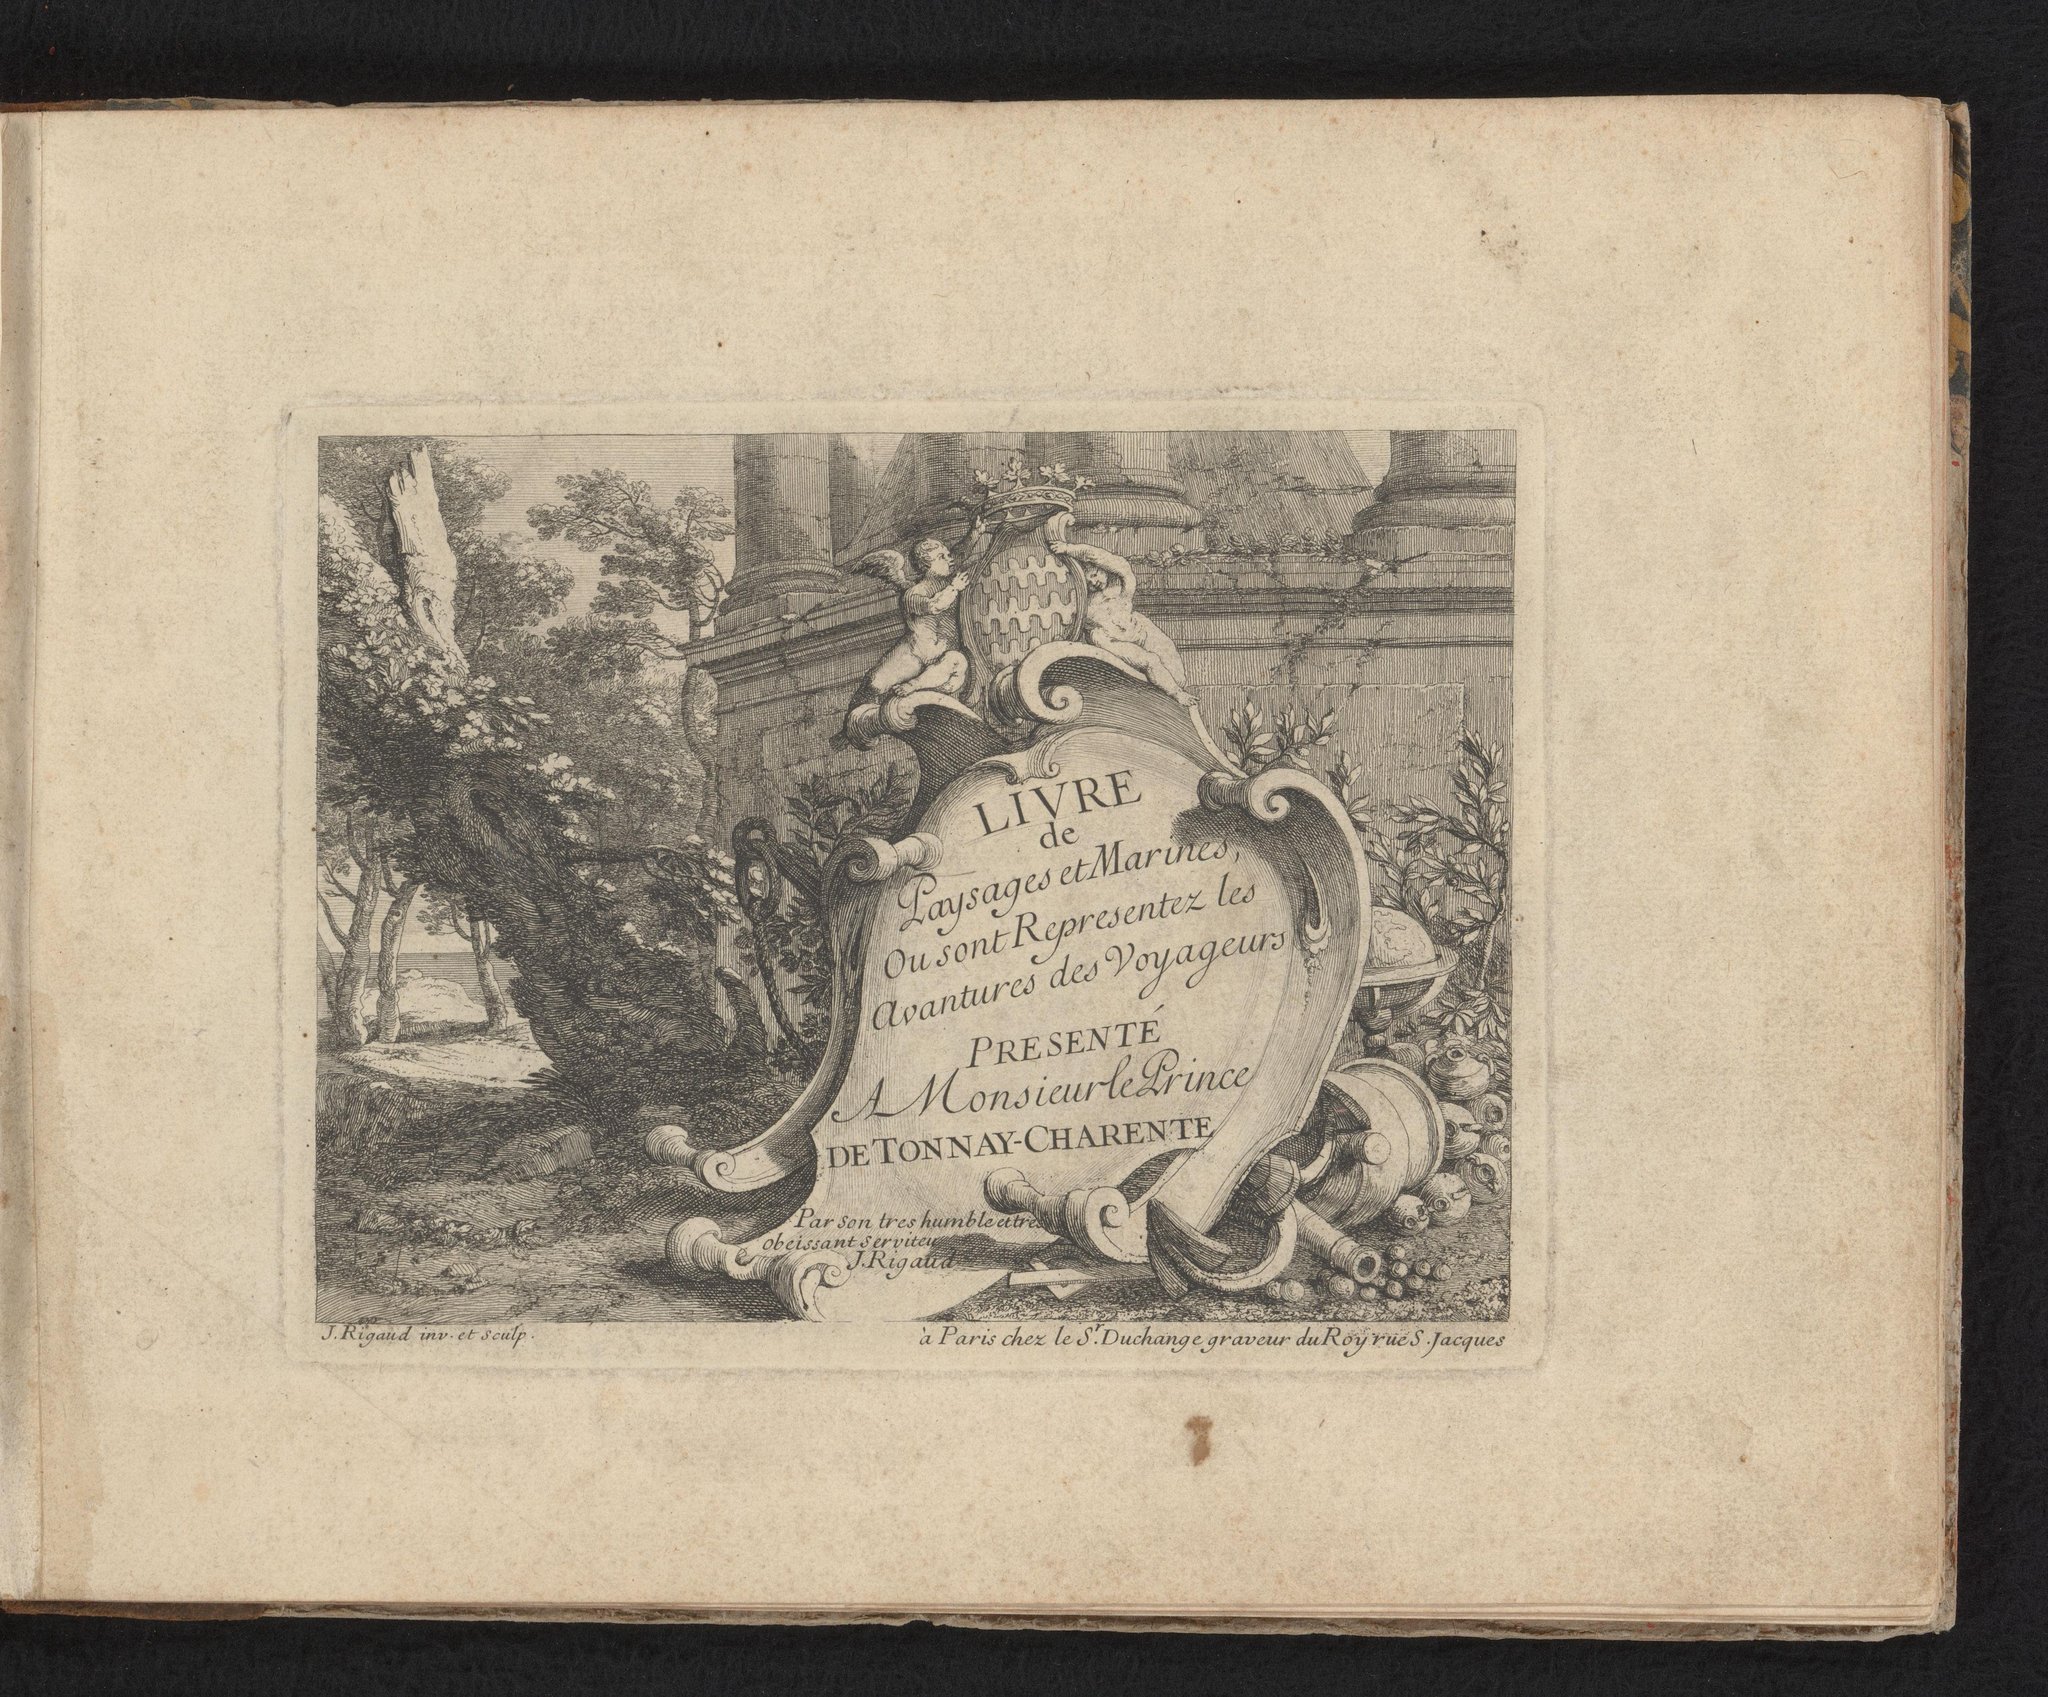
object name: print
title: Titelprent voor een serie landschappen met daarop de lotgevallen van reizigers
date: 1700-1725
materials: paper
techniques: etching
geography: paris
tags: landscapes, title-page, ornament ~ cartouche, globe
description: Deze prent maakt deel uit van een album.